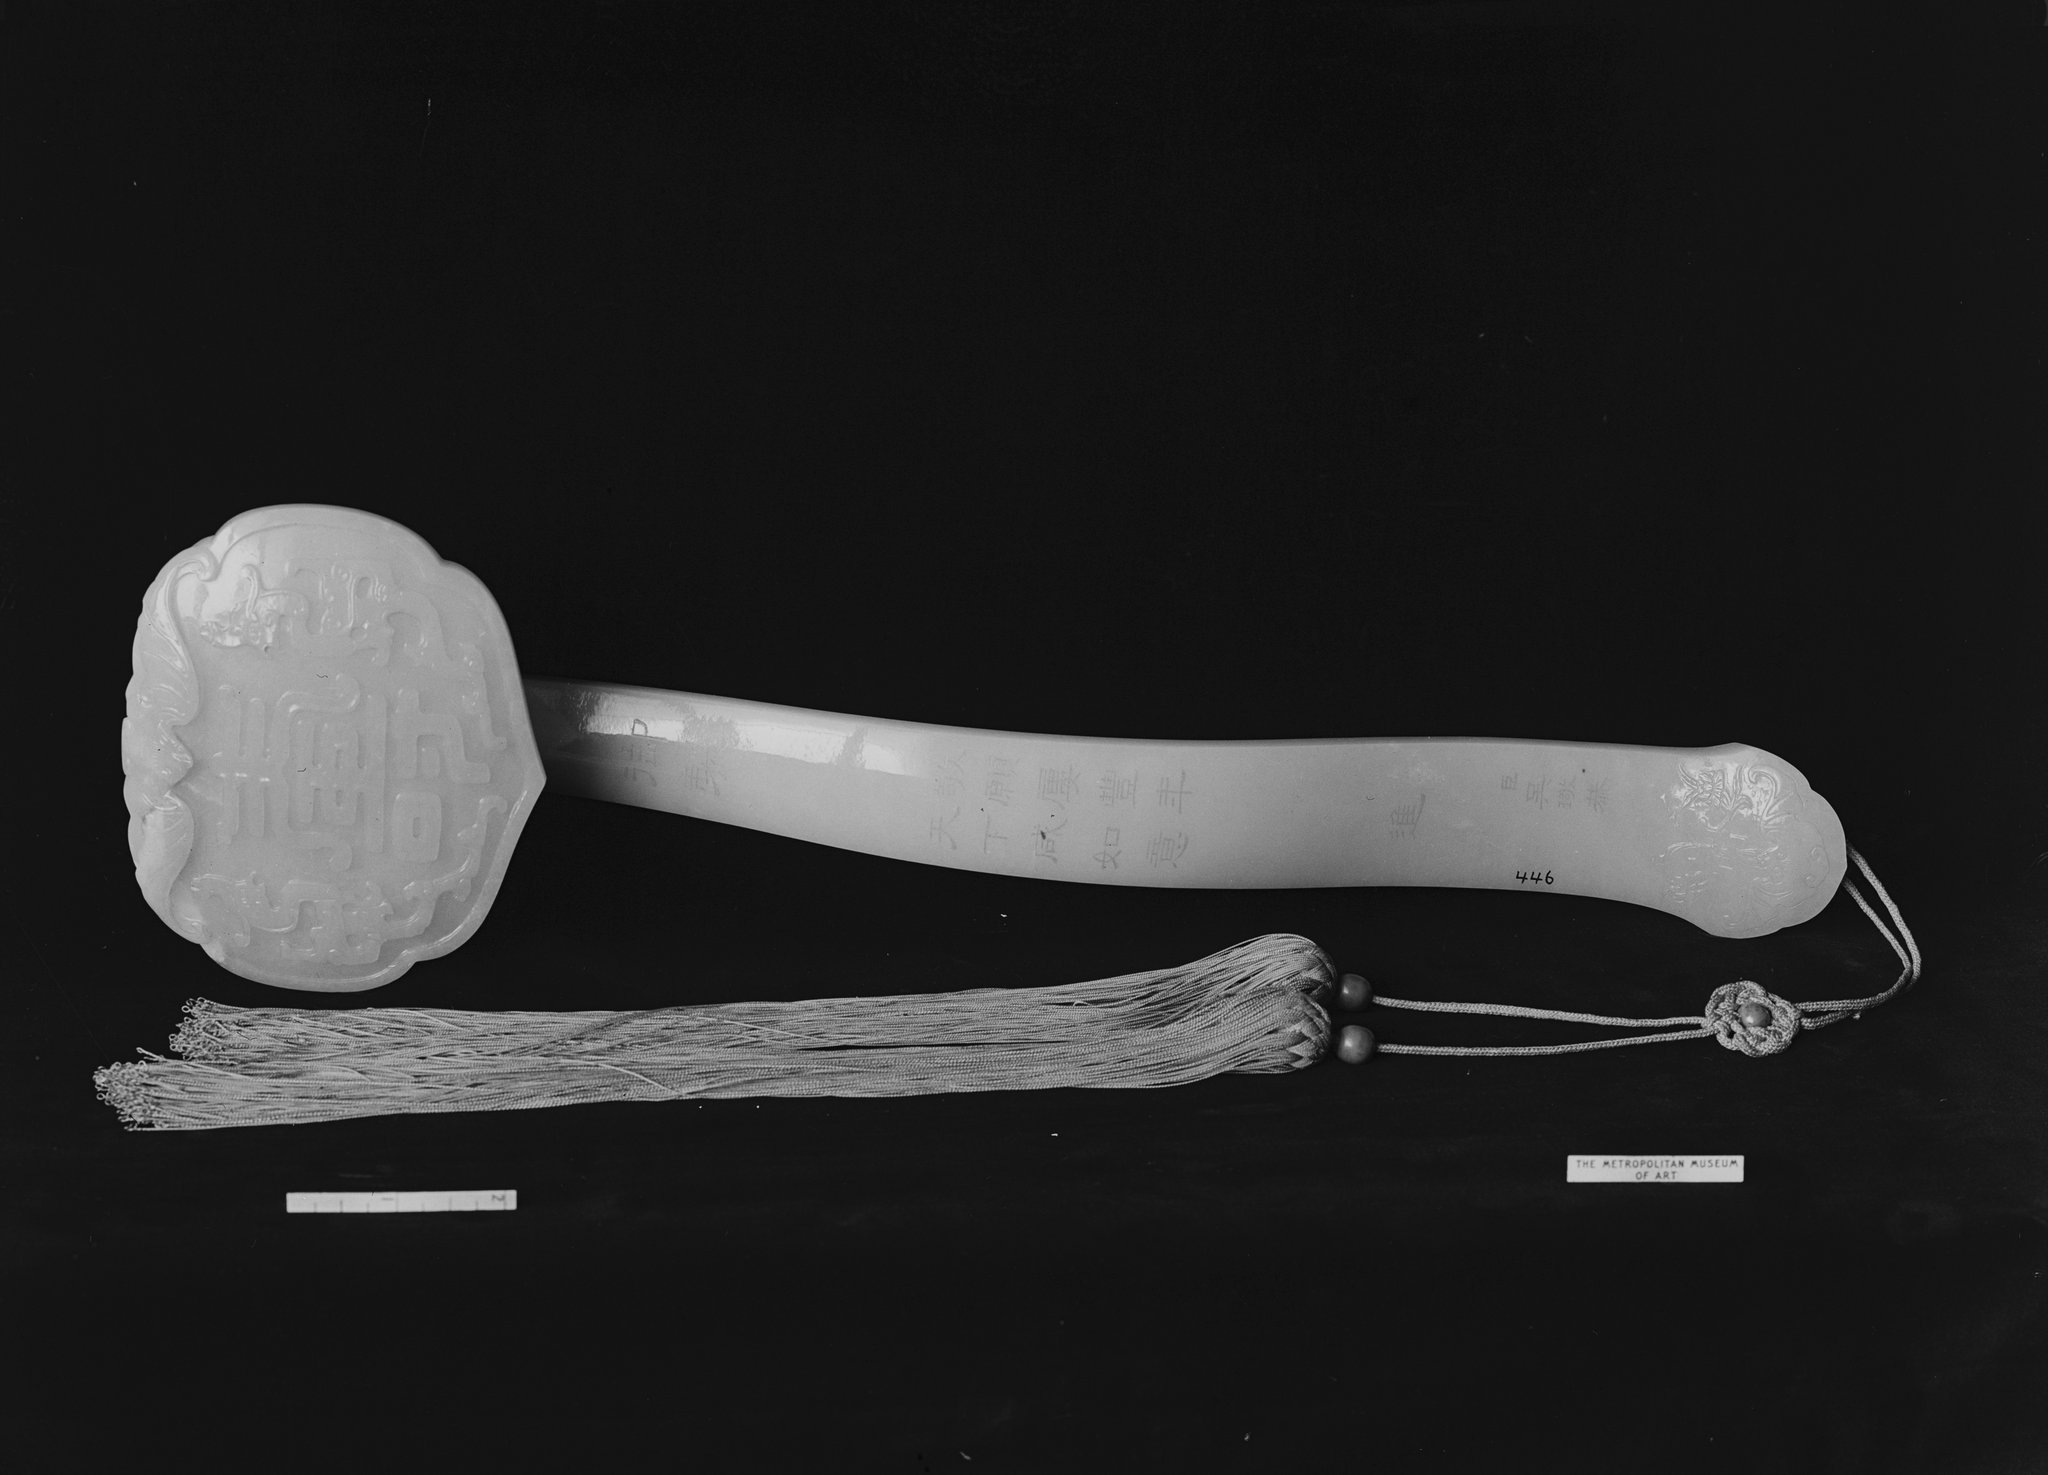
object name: ornament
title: Ornament (ruyi)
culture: chinese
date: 1701-1800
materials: jade